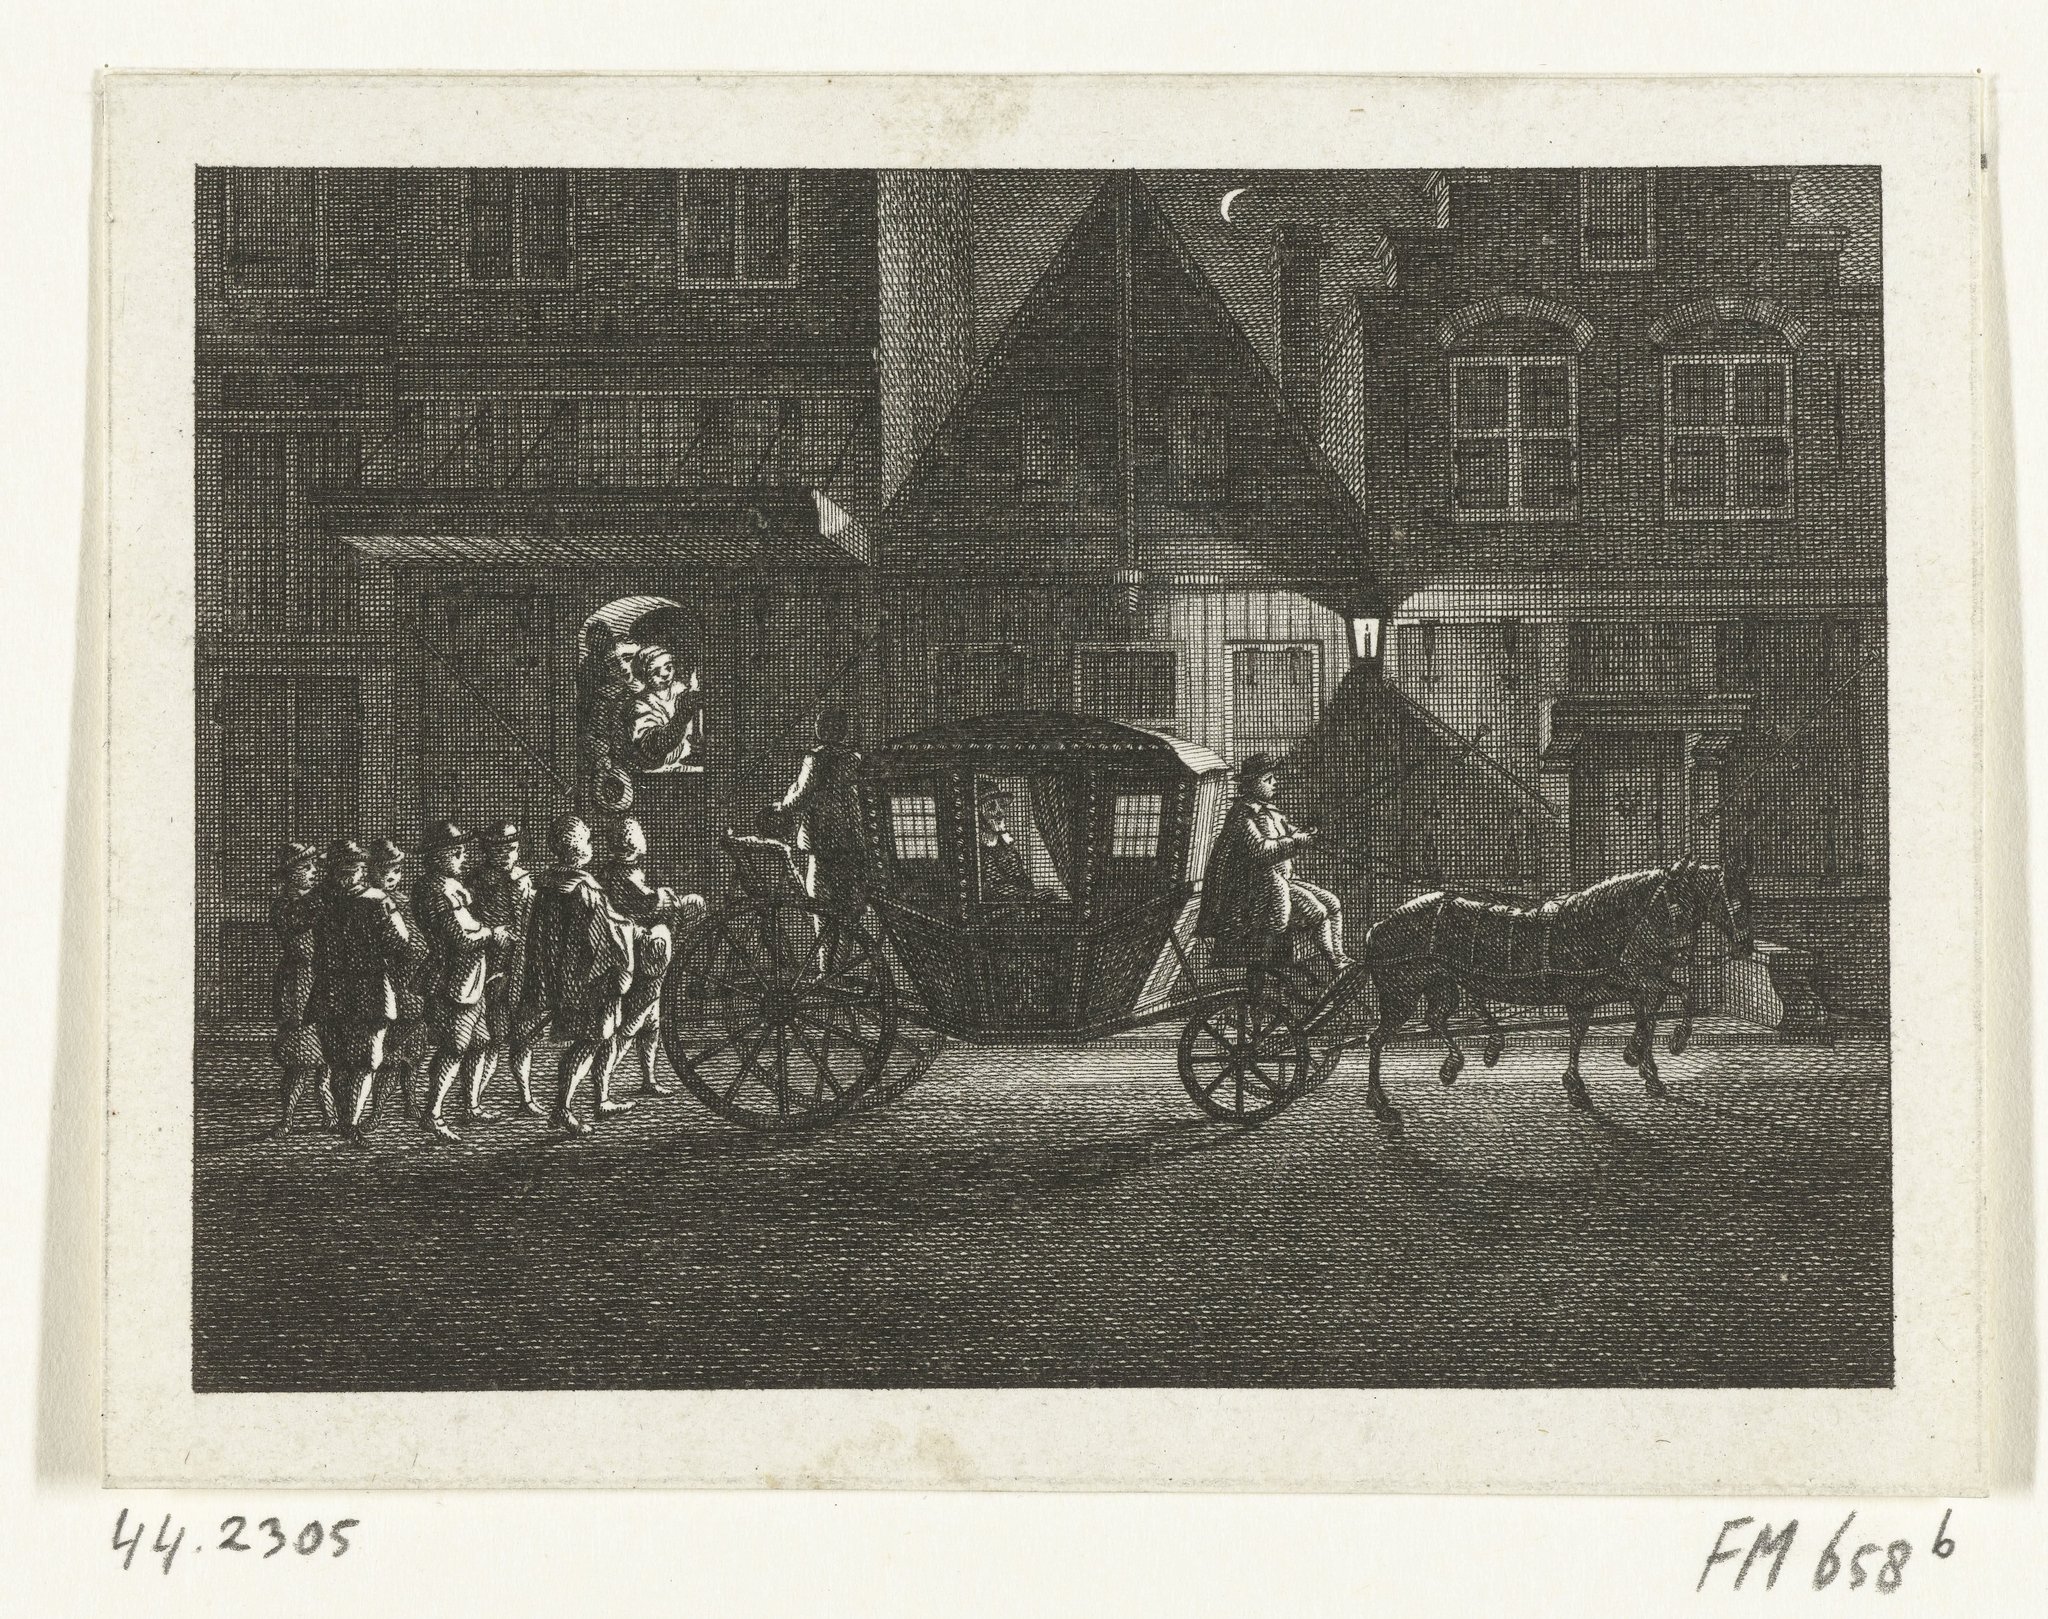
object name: history print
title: Vertrek van Alva uit Amsterdam, 1573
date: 1780-1782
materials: paper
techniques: etching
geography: netherlands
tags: fernando álvarez de toledo (3rd duke of alba), departure ~ travelling, amsterdam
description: Gebruikt als illustratie in: L. van Ollefen, Verkorte beschryving van Amsteldam, geschikt voor de opvoeding der jeugd, J.B. Elwe, Amsterdam 1782. Staat vóór de letter.